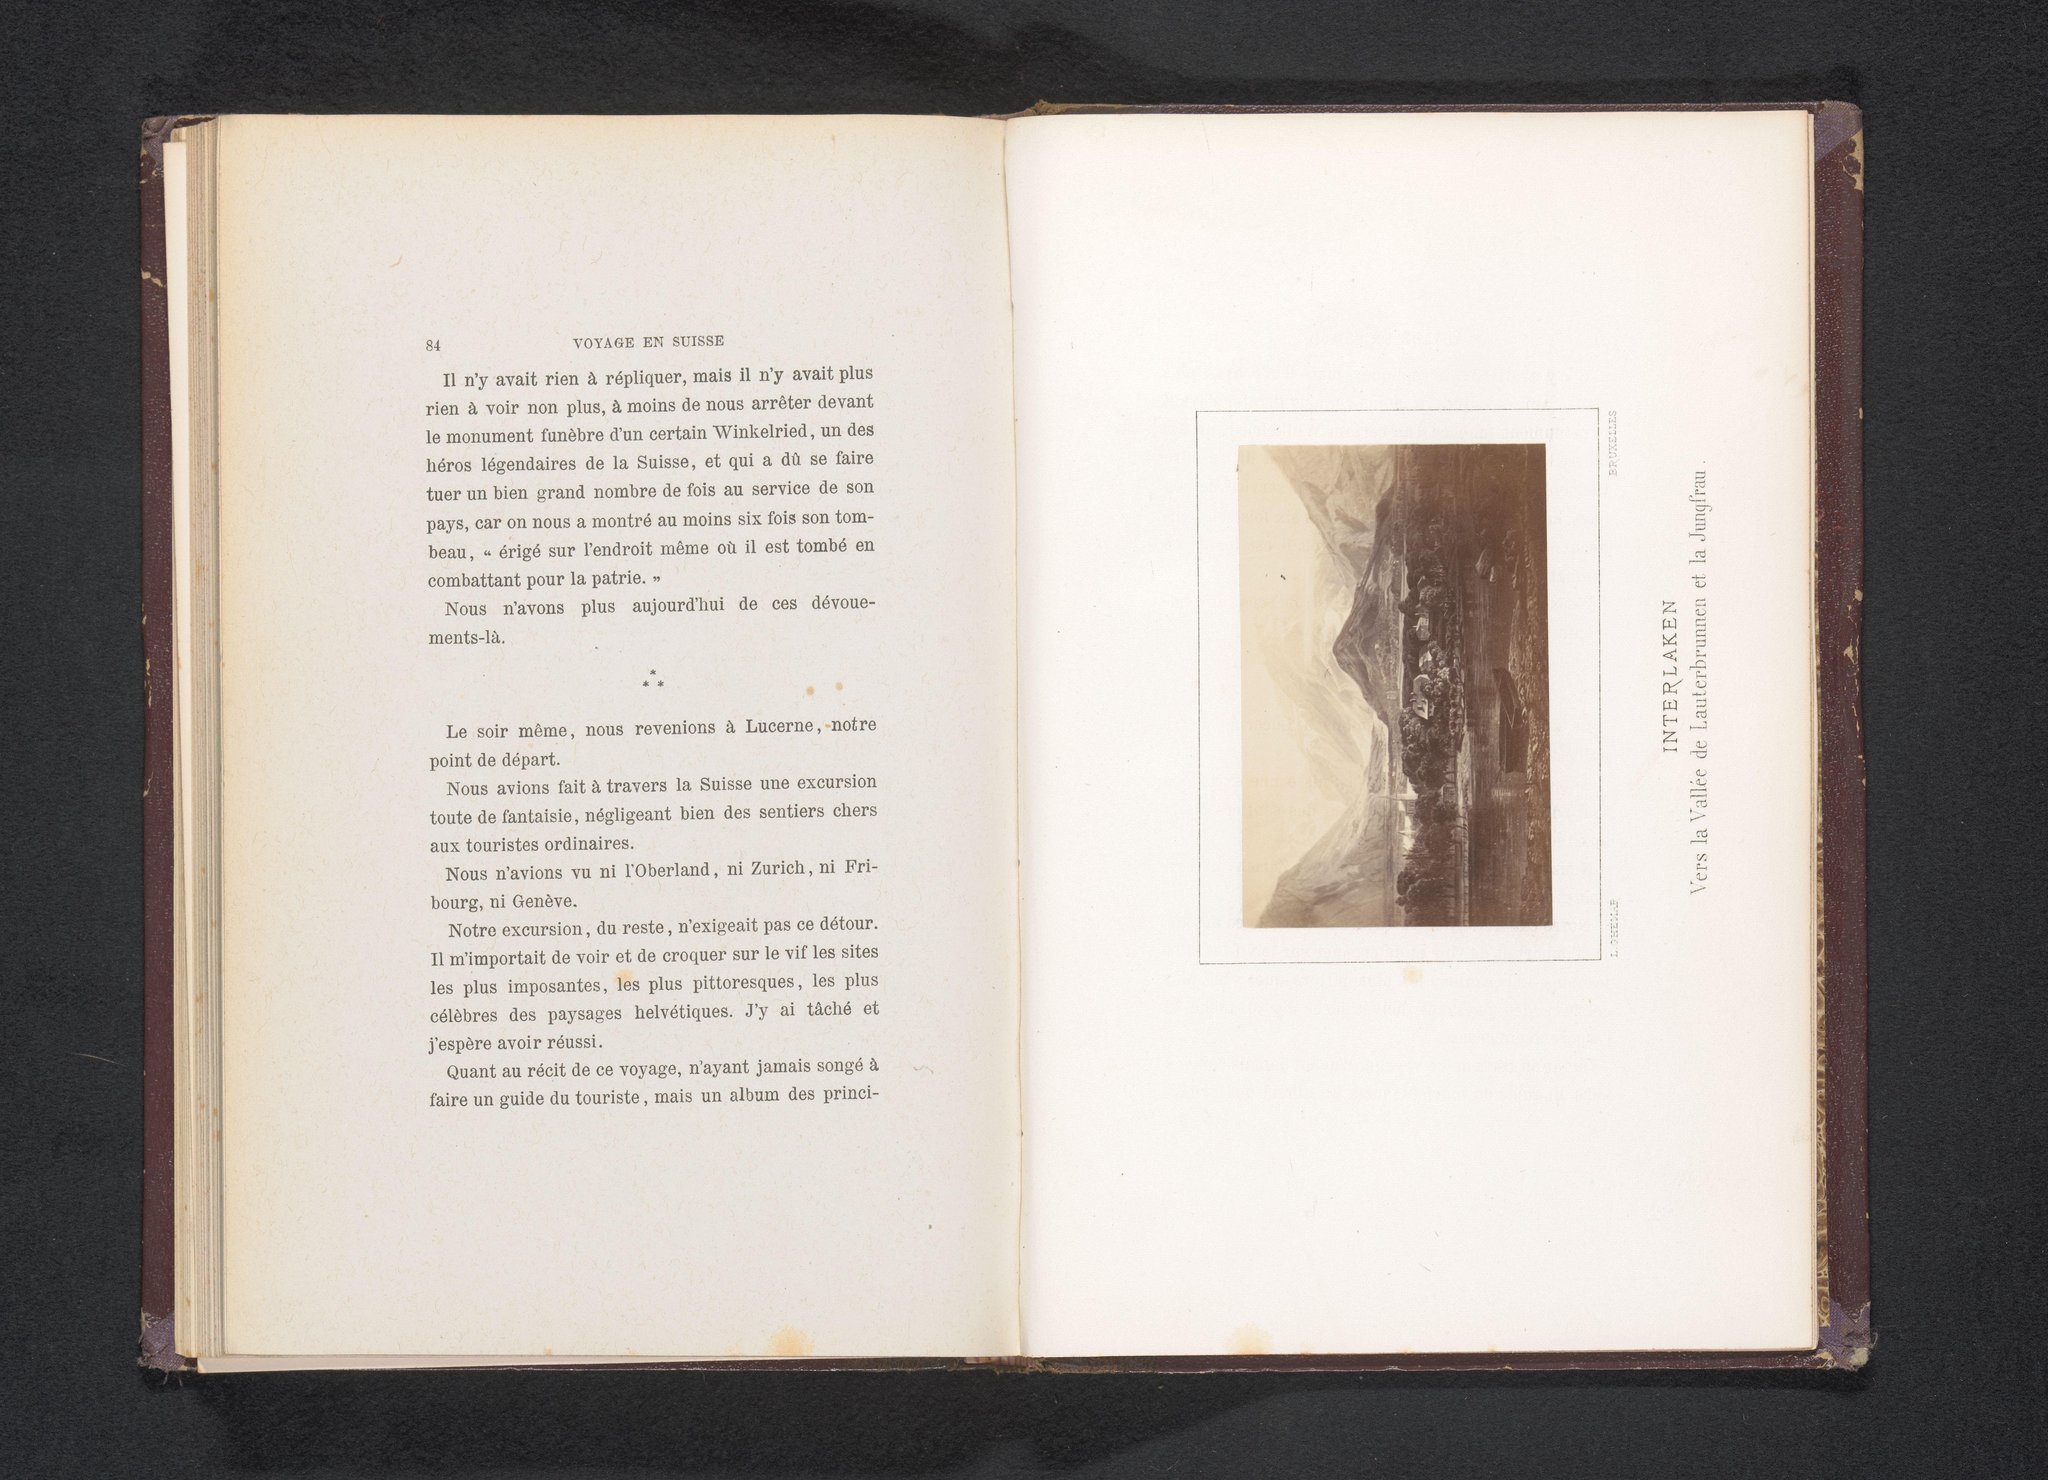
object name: page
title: Gezicht op Interlaken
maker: louis ghémar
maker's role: draughtsman, print maker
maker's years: 1819-1873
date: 1863-1868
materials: photographic support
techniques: albumen print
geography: interlaken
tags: city-view in general; 'veduta', mountain-range, snow peaks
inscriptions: inscription: ‘Bruxelles’